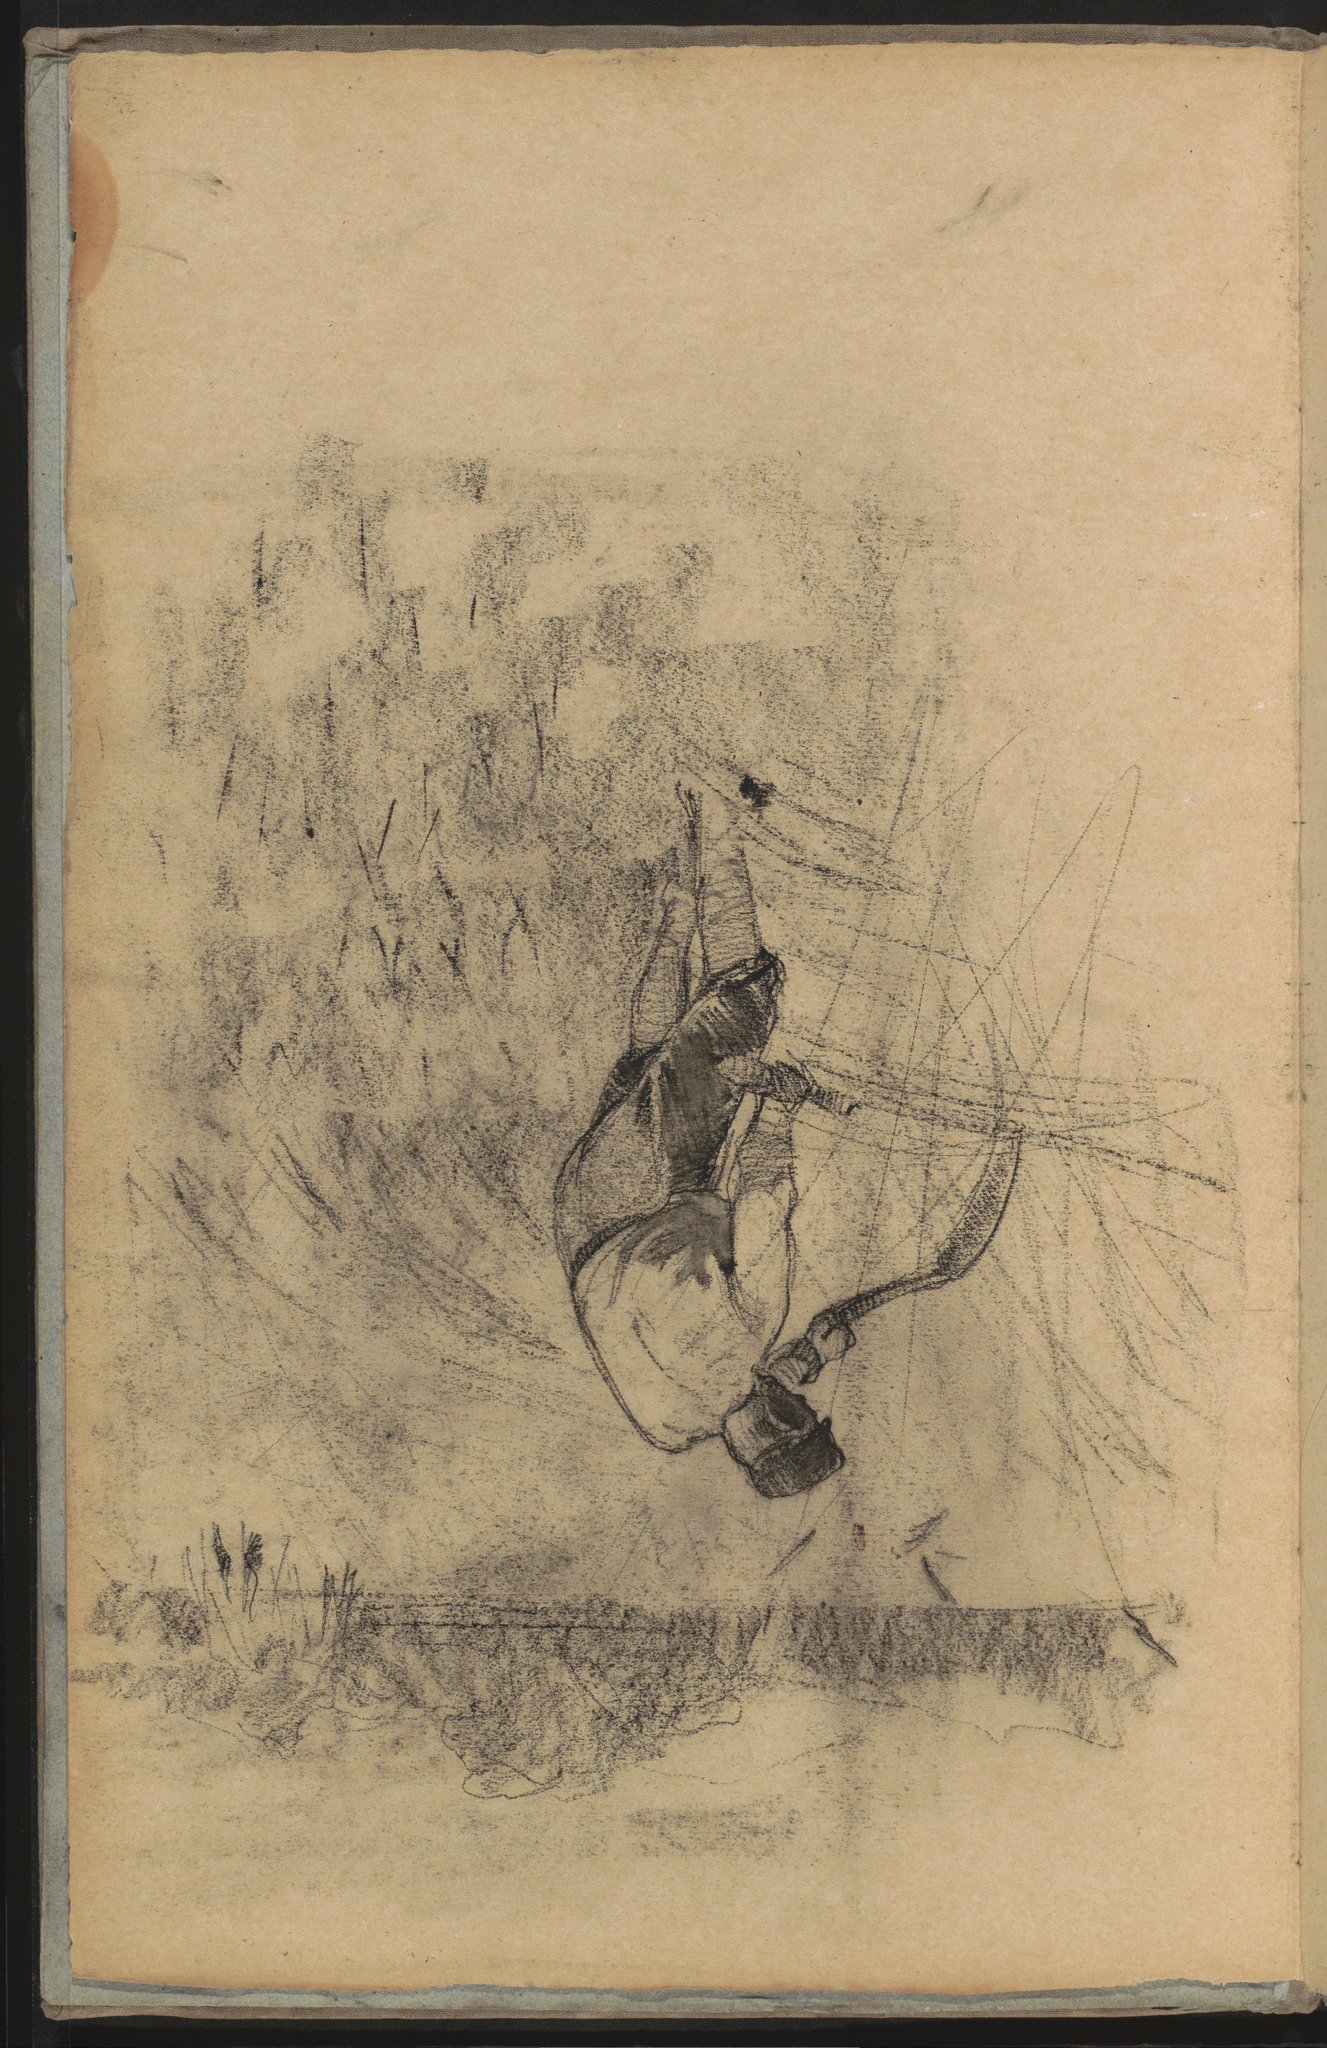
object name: sketchbook leaf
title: Boer met een zeis op het land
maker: willem witsen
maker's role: draughtsman, painter, print maker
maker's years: 1860-1923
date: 1884-1887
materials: chalk, paper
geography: ewijkshoeve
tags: agricultural implements: scythe, cultivation ~ agriculture (+ men (labourers)), farmers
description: Pagina 12 uit een schetsboek met 42 bladen vervaardigd rond de Ewijkshoeve.